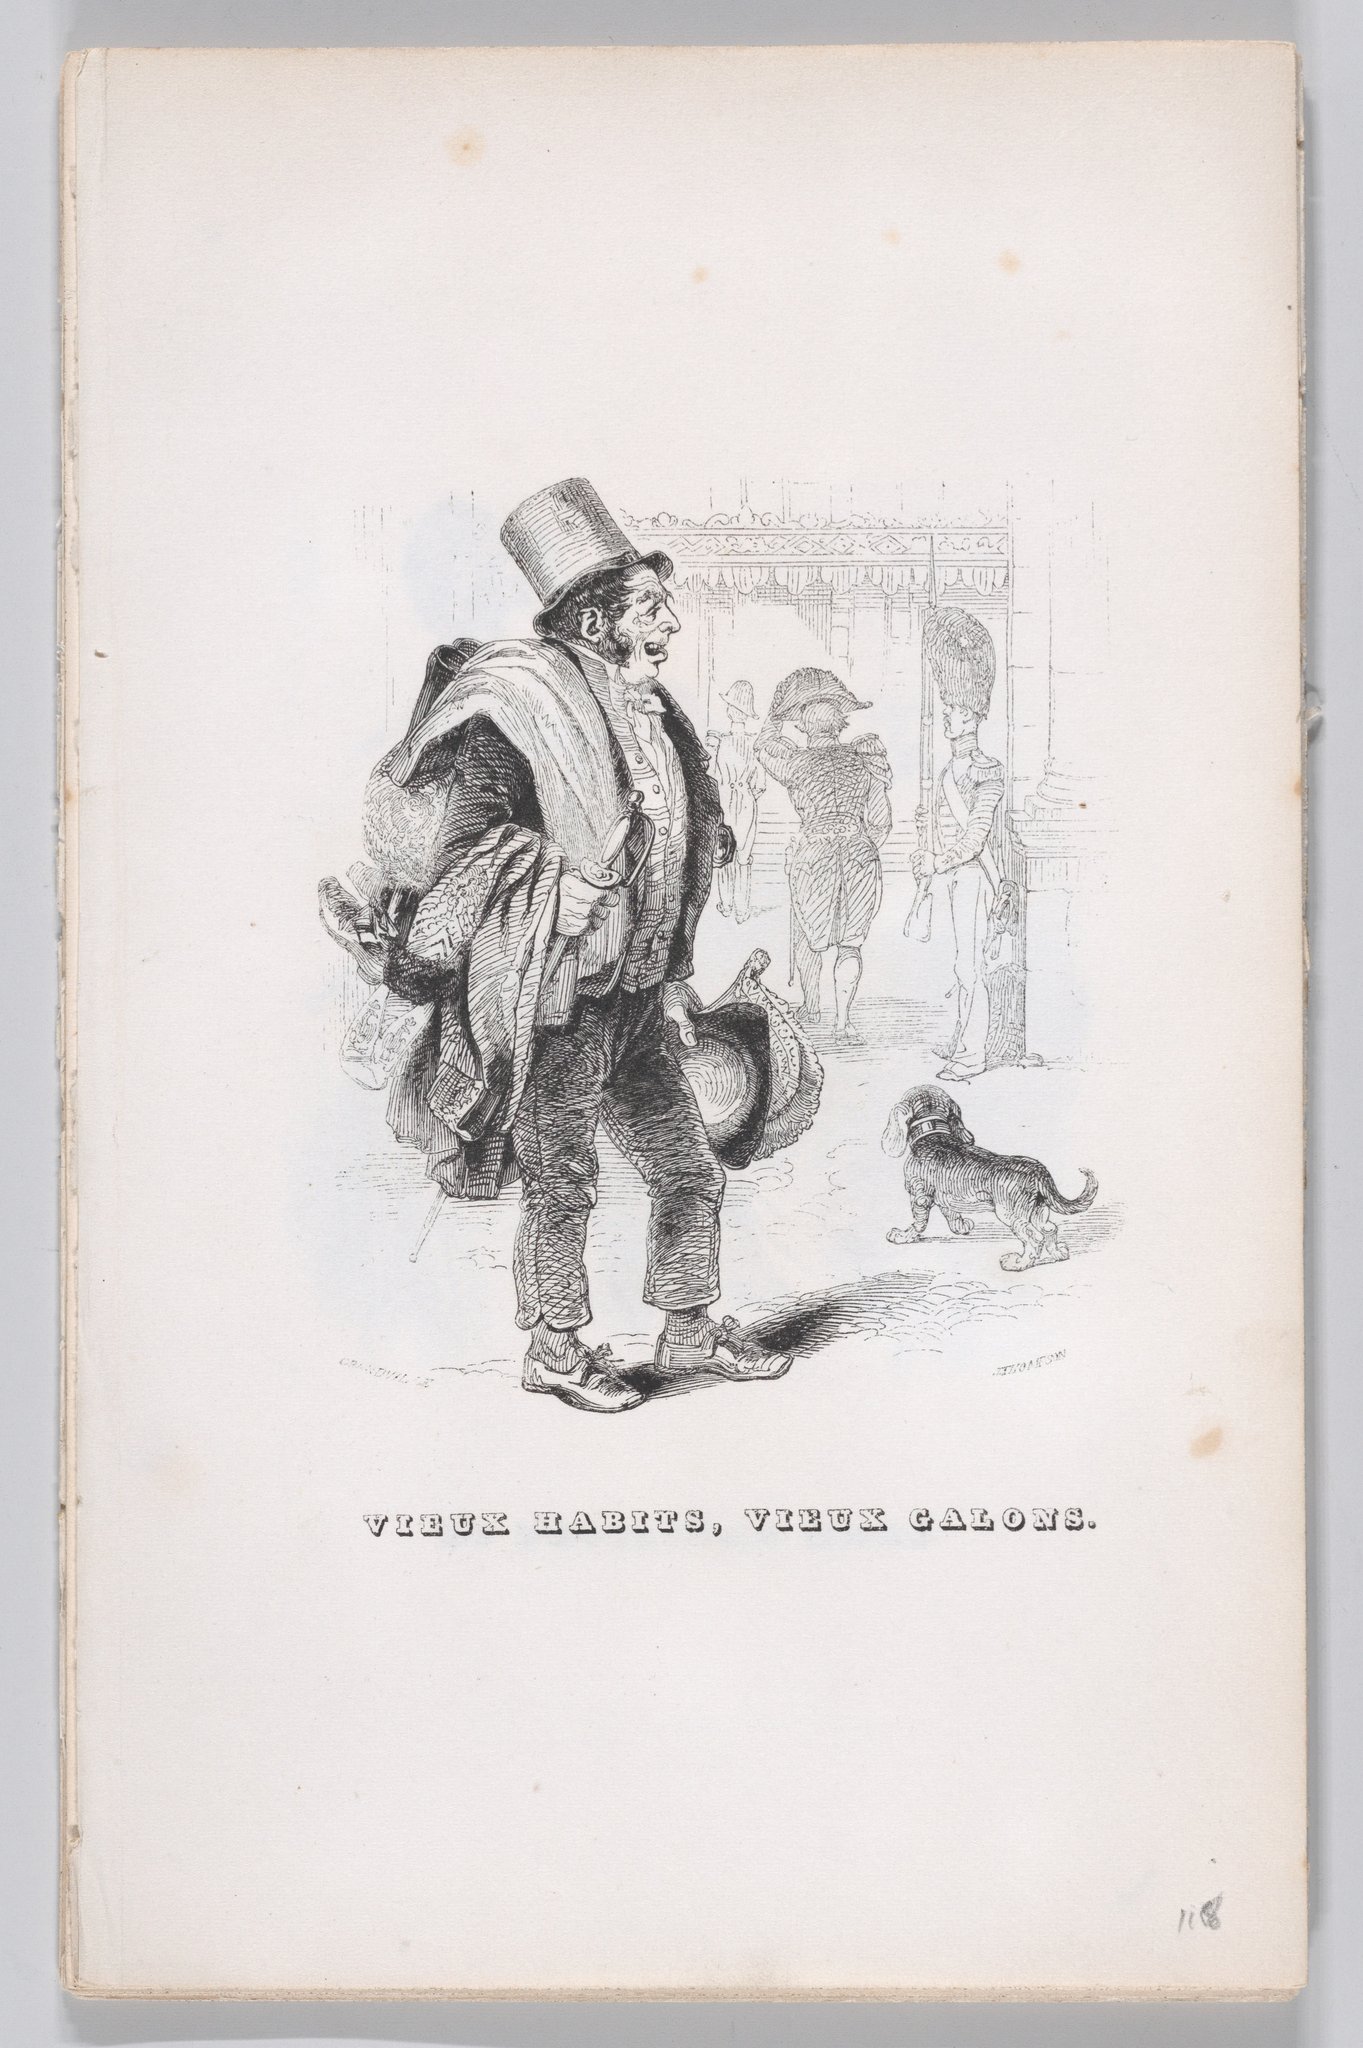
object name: print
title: Old clothes, old military stripes, from "The Complete Works of Béranger"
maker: j. j. grandville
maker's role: illustrator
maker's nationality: french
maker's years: 1803-1847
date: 1836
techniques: engraving